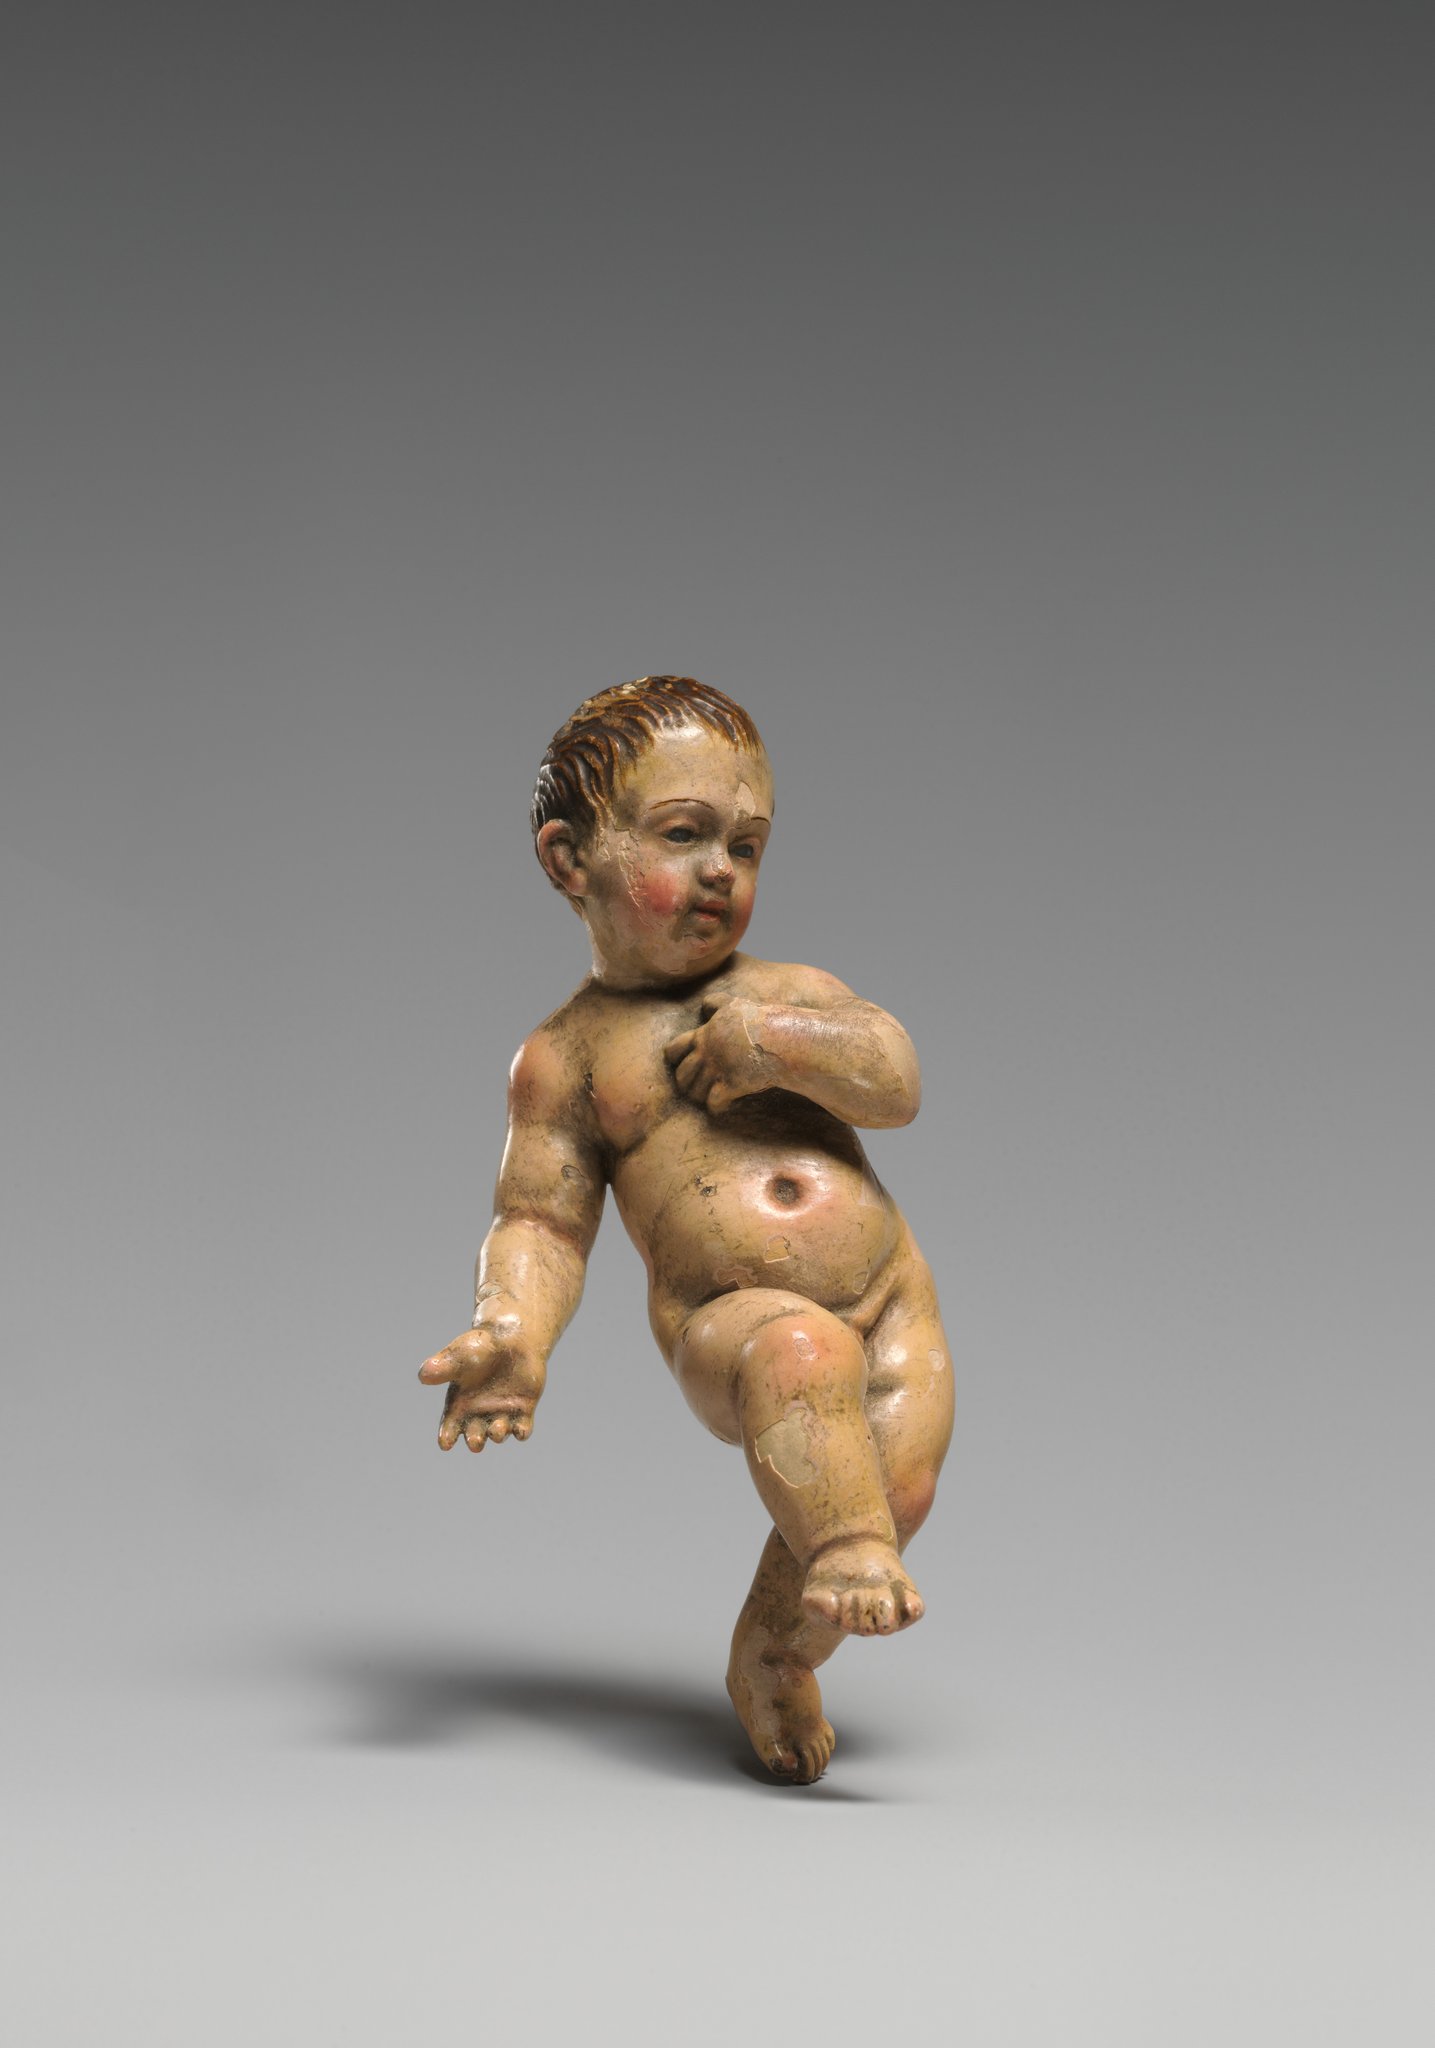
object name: crèche figure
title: Infant Jesus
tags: jesus